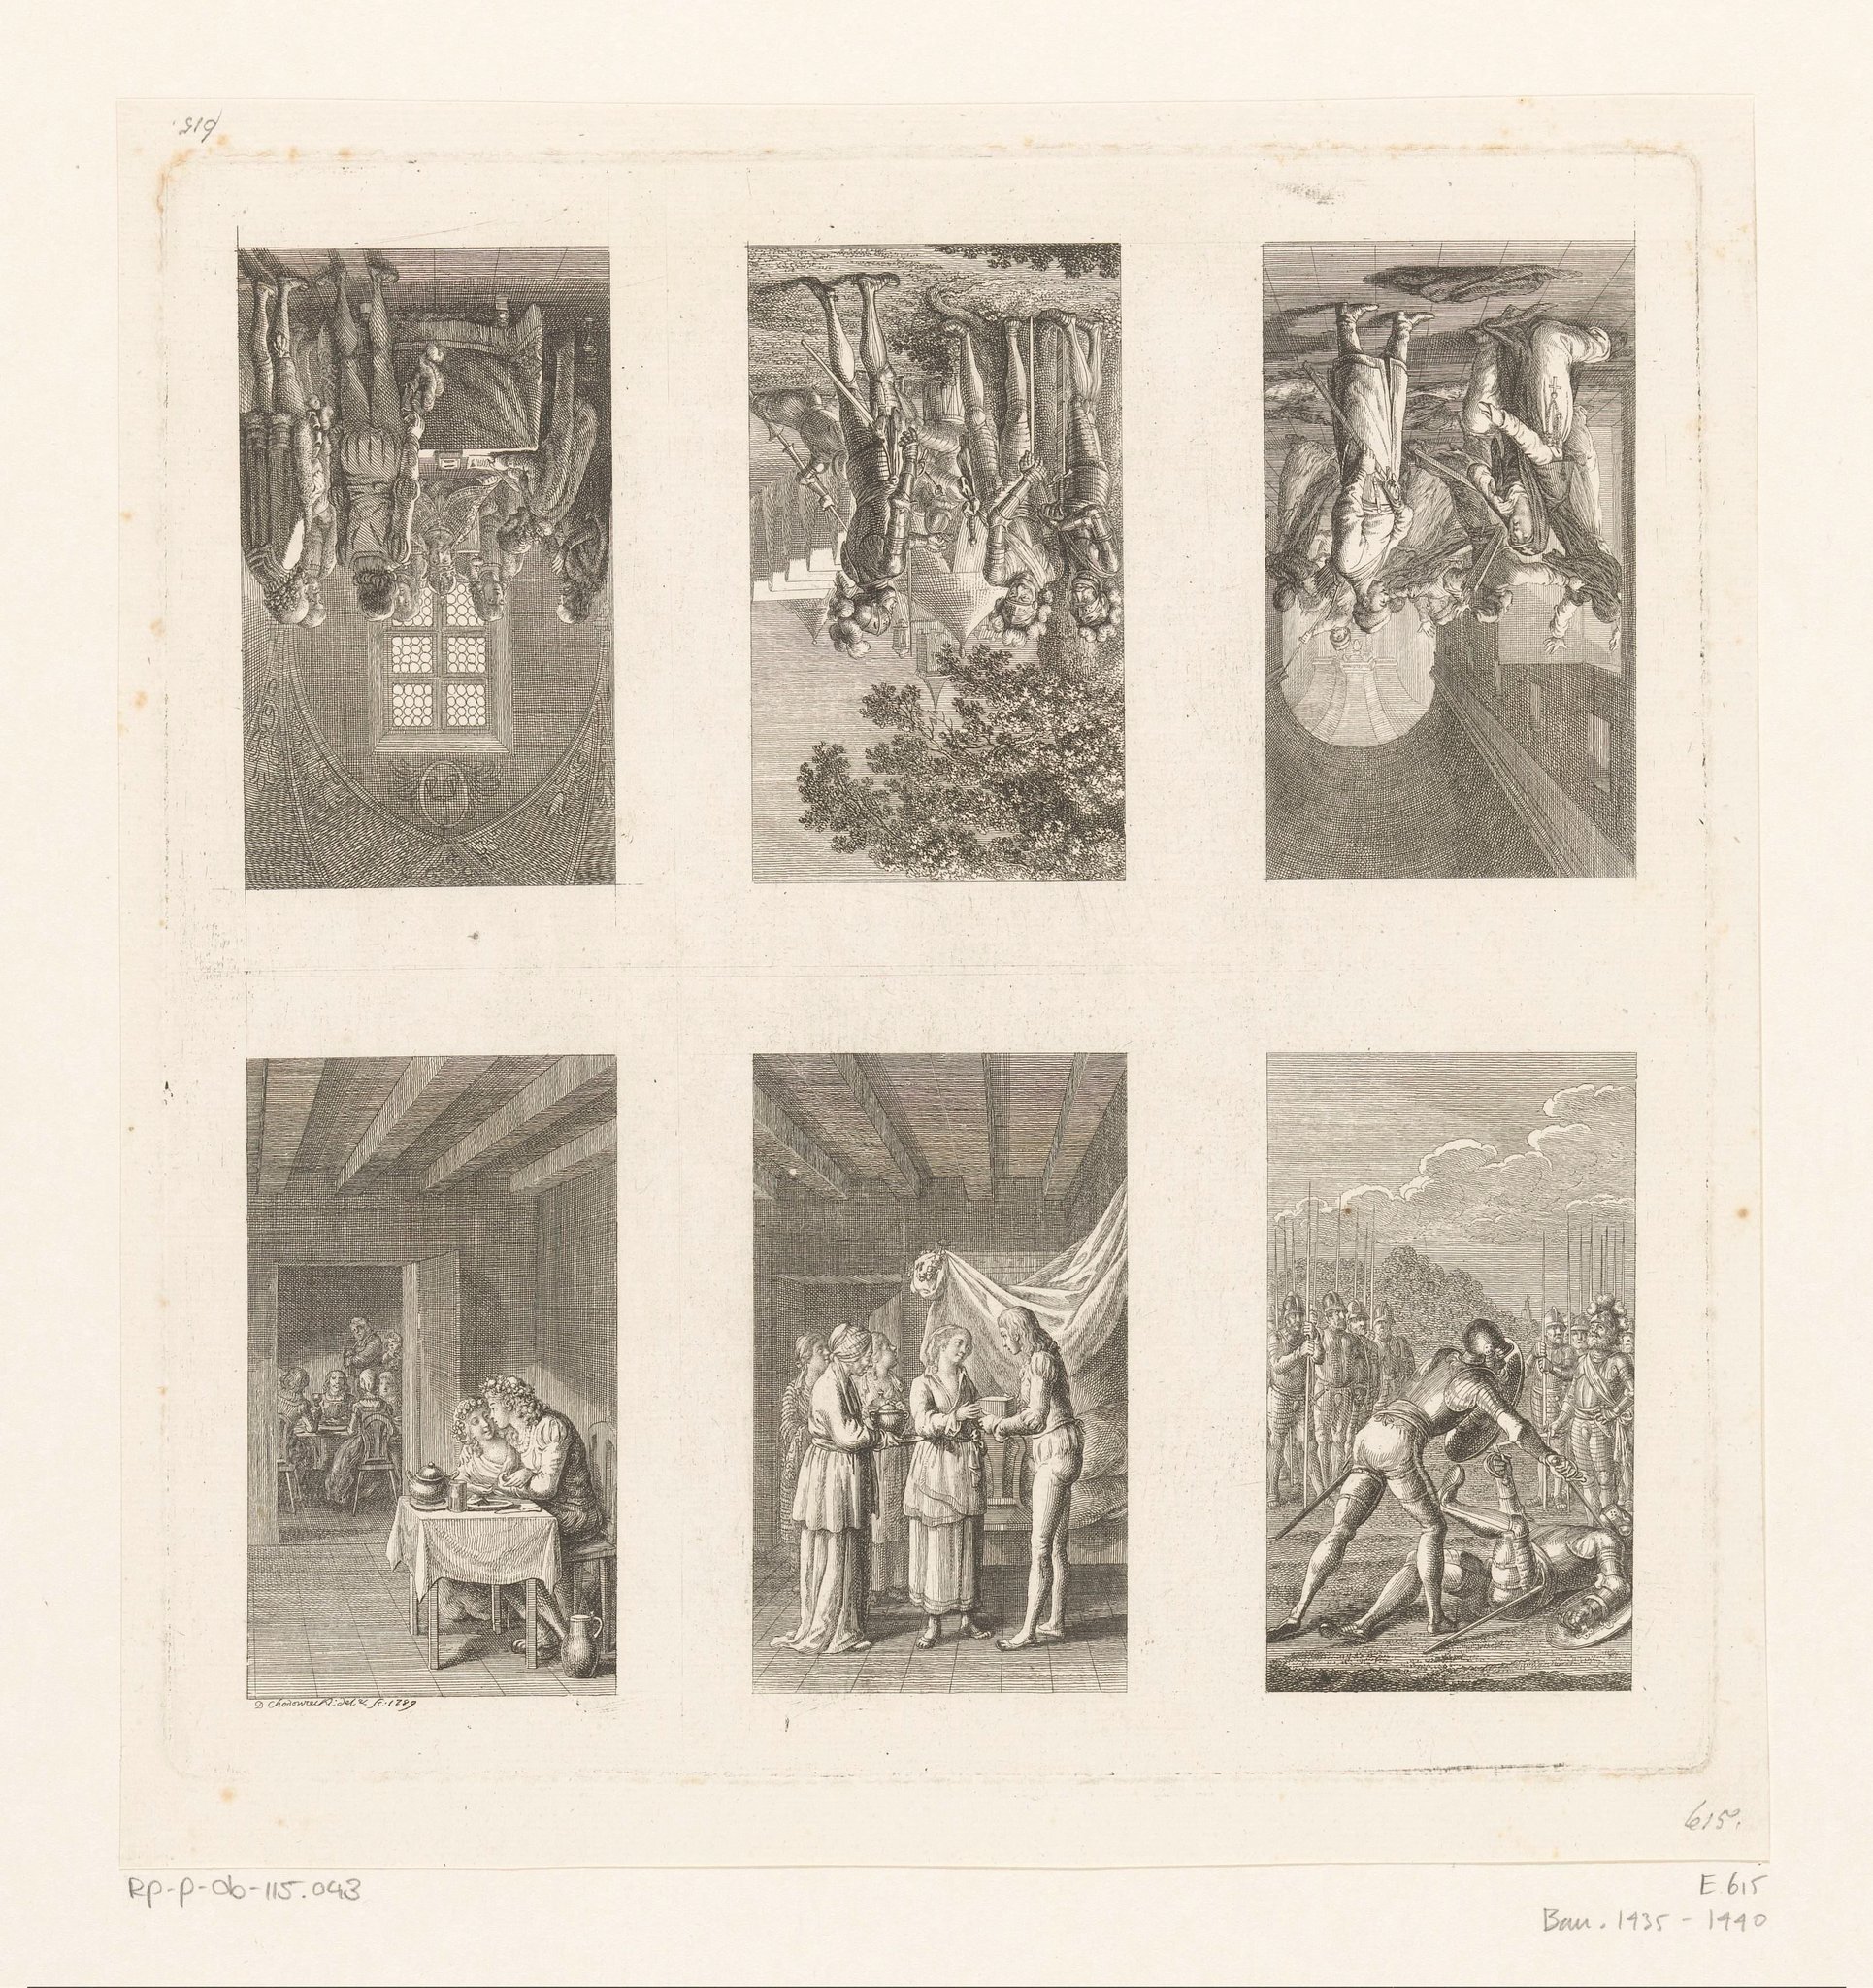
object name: print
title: Zes voorstellingen uit de Pruisisch-Brandenburgse staatsgeschiedenis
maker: daniel nikolaus chodowiecki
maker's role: draughtsman, print maker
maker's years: 1726-1801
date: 1789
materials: paper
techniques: etching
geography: berlin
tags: (military) camp with tents, history, nun(s), armour, ruler, sovereign, fighting, lovers; courting, flirting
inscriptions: collector's mark: Lugt 2228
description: Vervaardigd voor de 'Pruisisch-Brandenburgse staatsgeschiedenis'. Latere staat gebruikt voor: Historisch Genealogischer Calender auf das Jahr 1790. 2 dln. Berlijn: s.n., [1789], dl. 1.